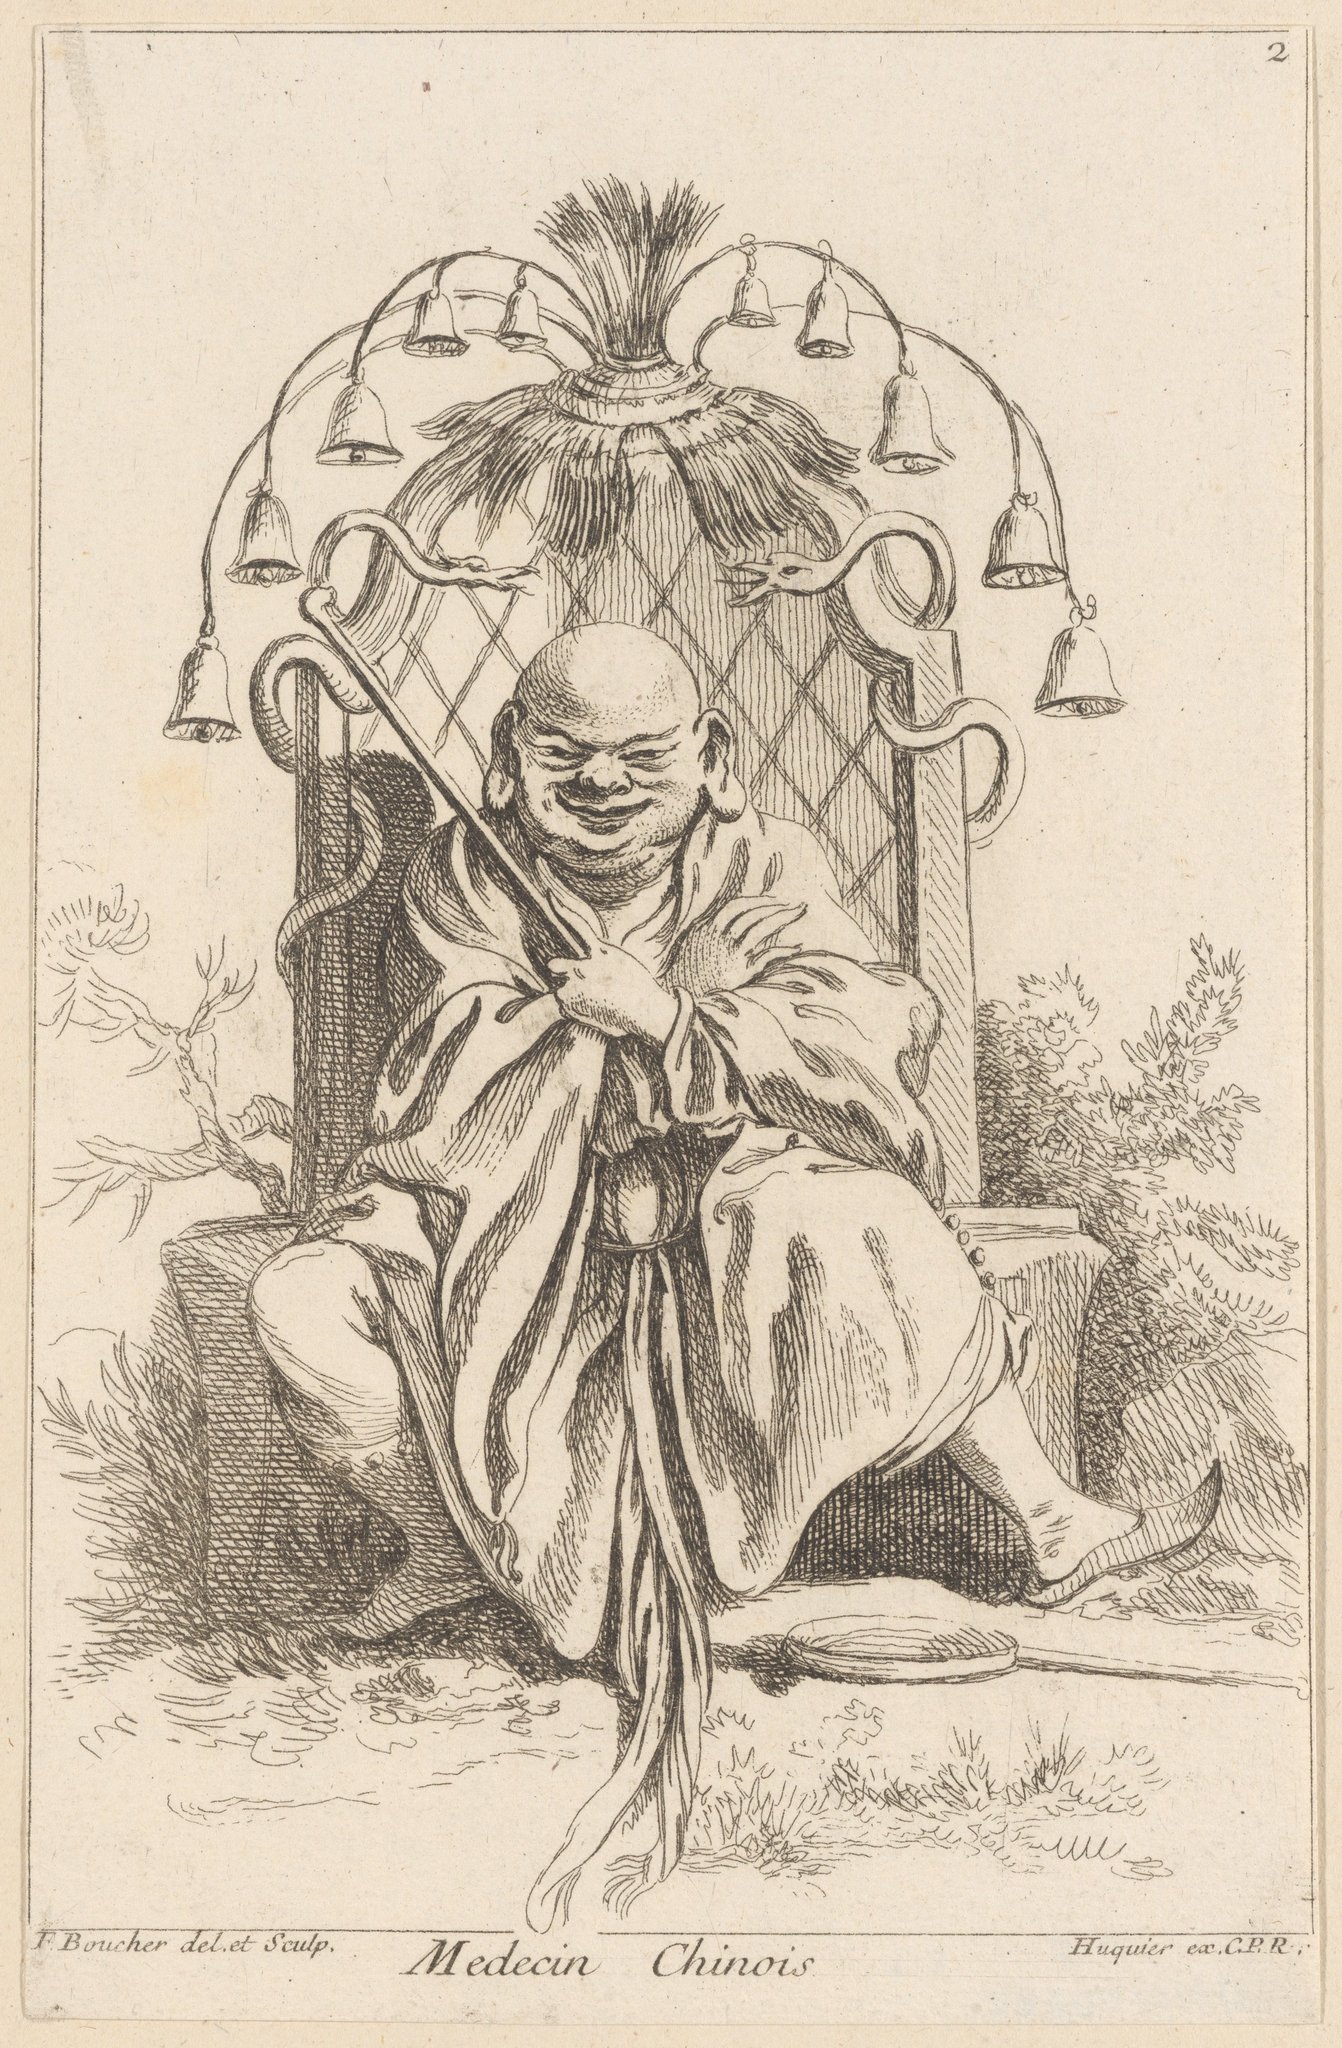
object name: print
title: Chinese doctor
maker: françois boucher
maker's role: artist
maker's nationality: french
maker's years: 1703-1770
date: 1738-1745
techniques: etching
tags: men,doctors